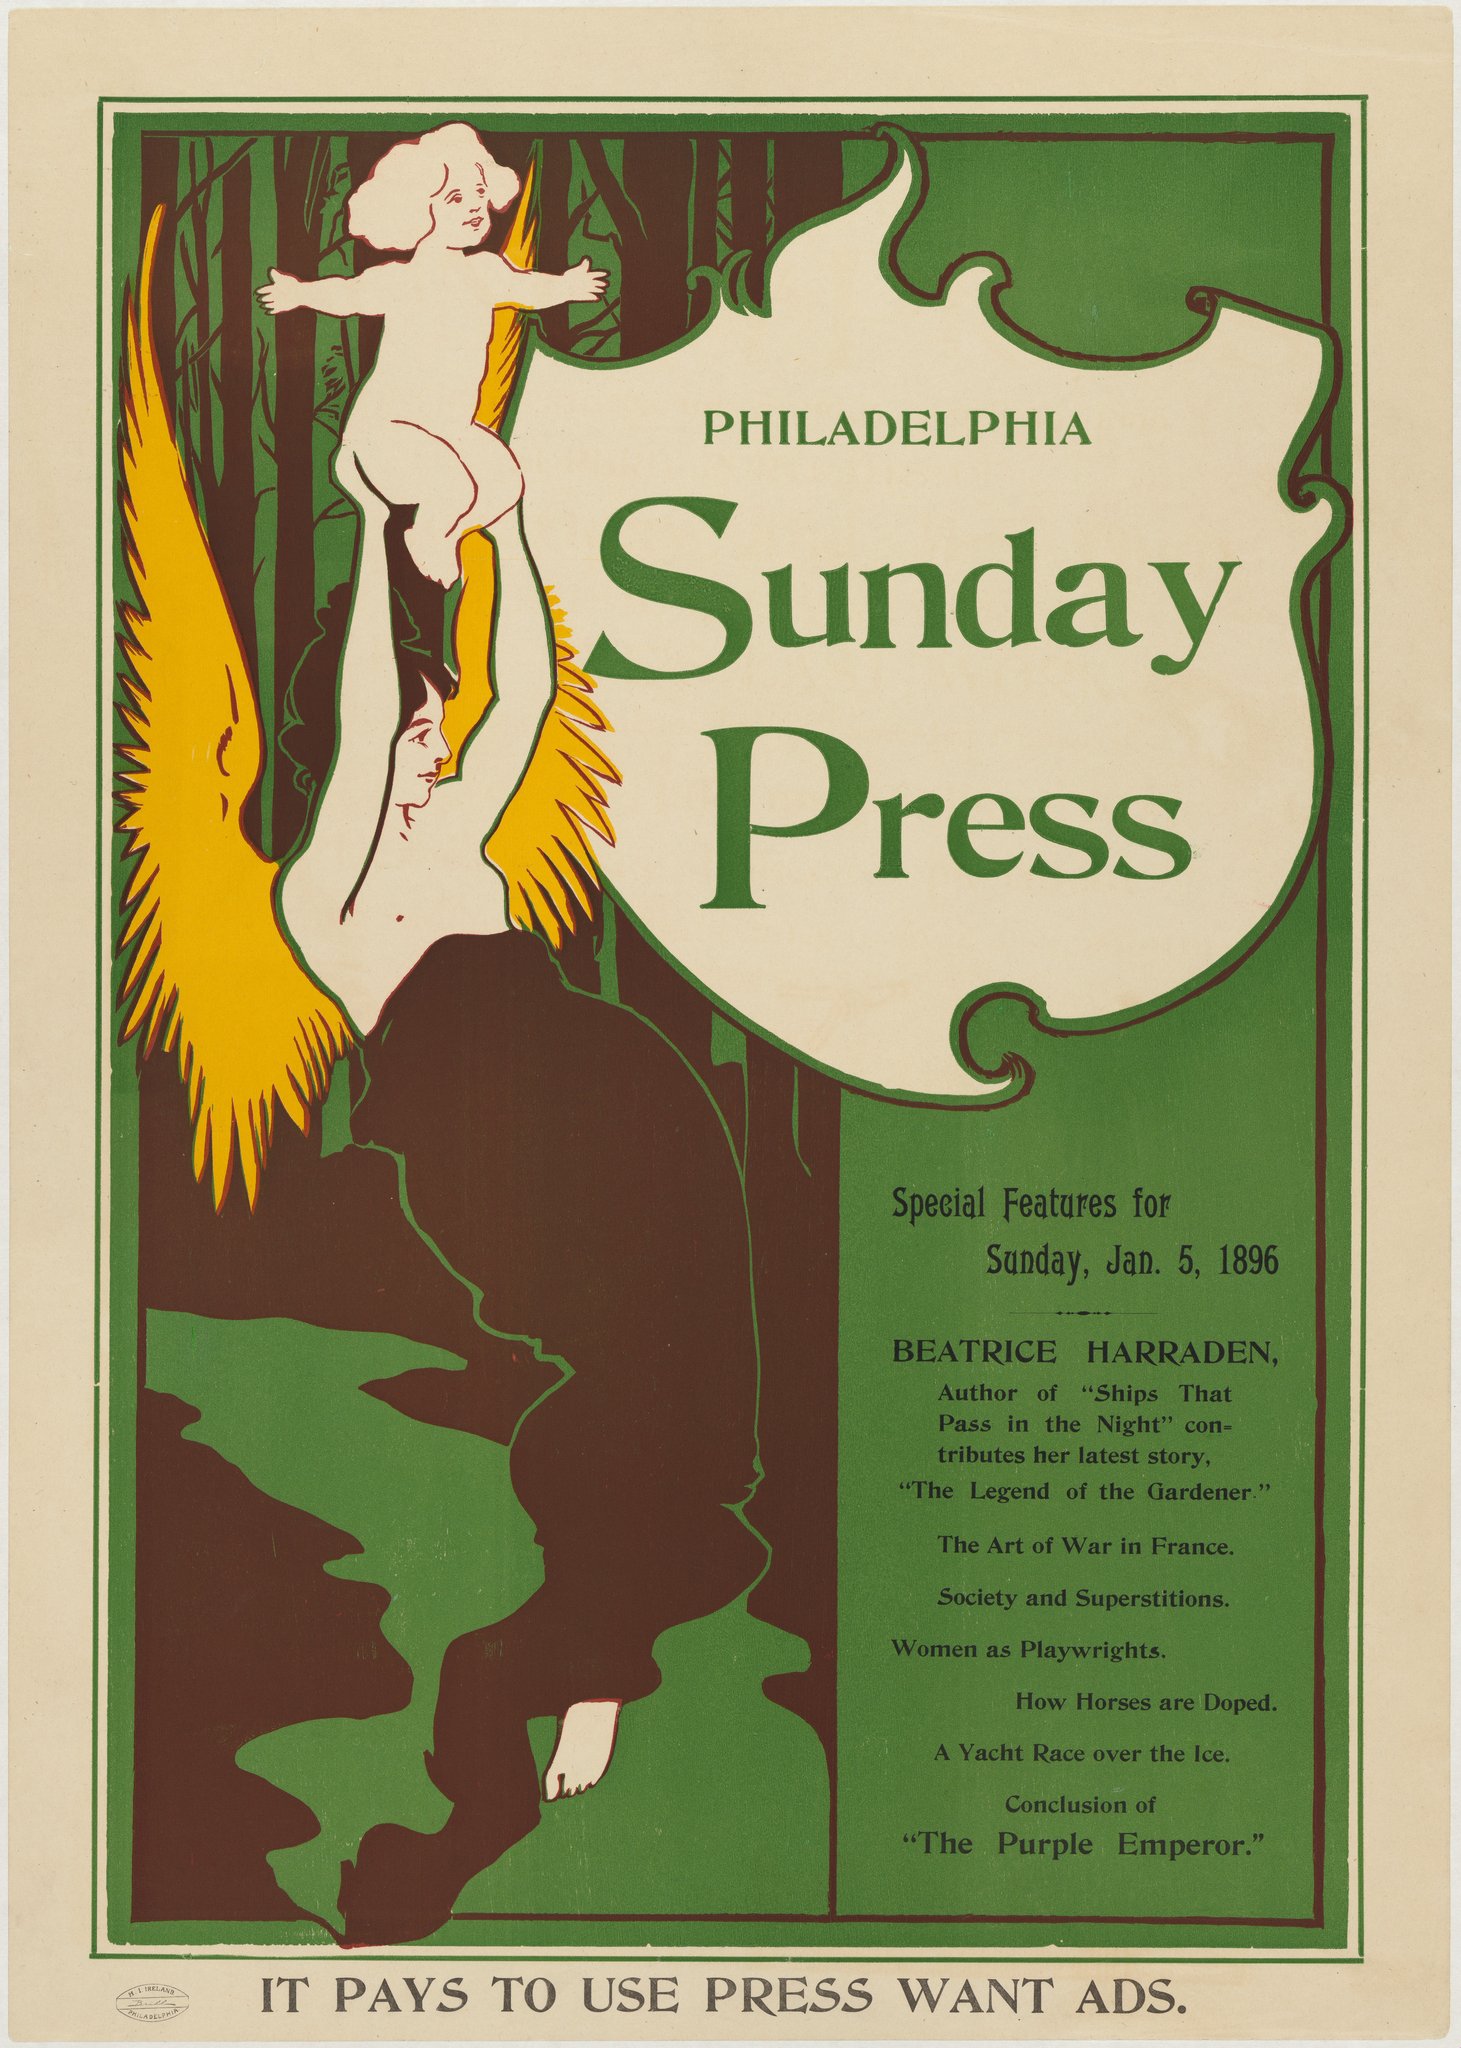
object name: poster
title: Advertisement for Philadelphia Sunday Press, Jan. 5, 1896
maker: george reiter brill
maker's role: artist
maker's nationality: american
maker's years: 1867-1918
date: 1896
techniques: lithograph